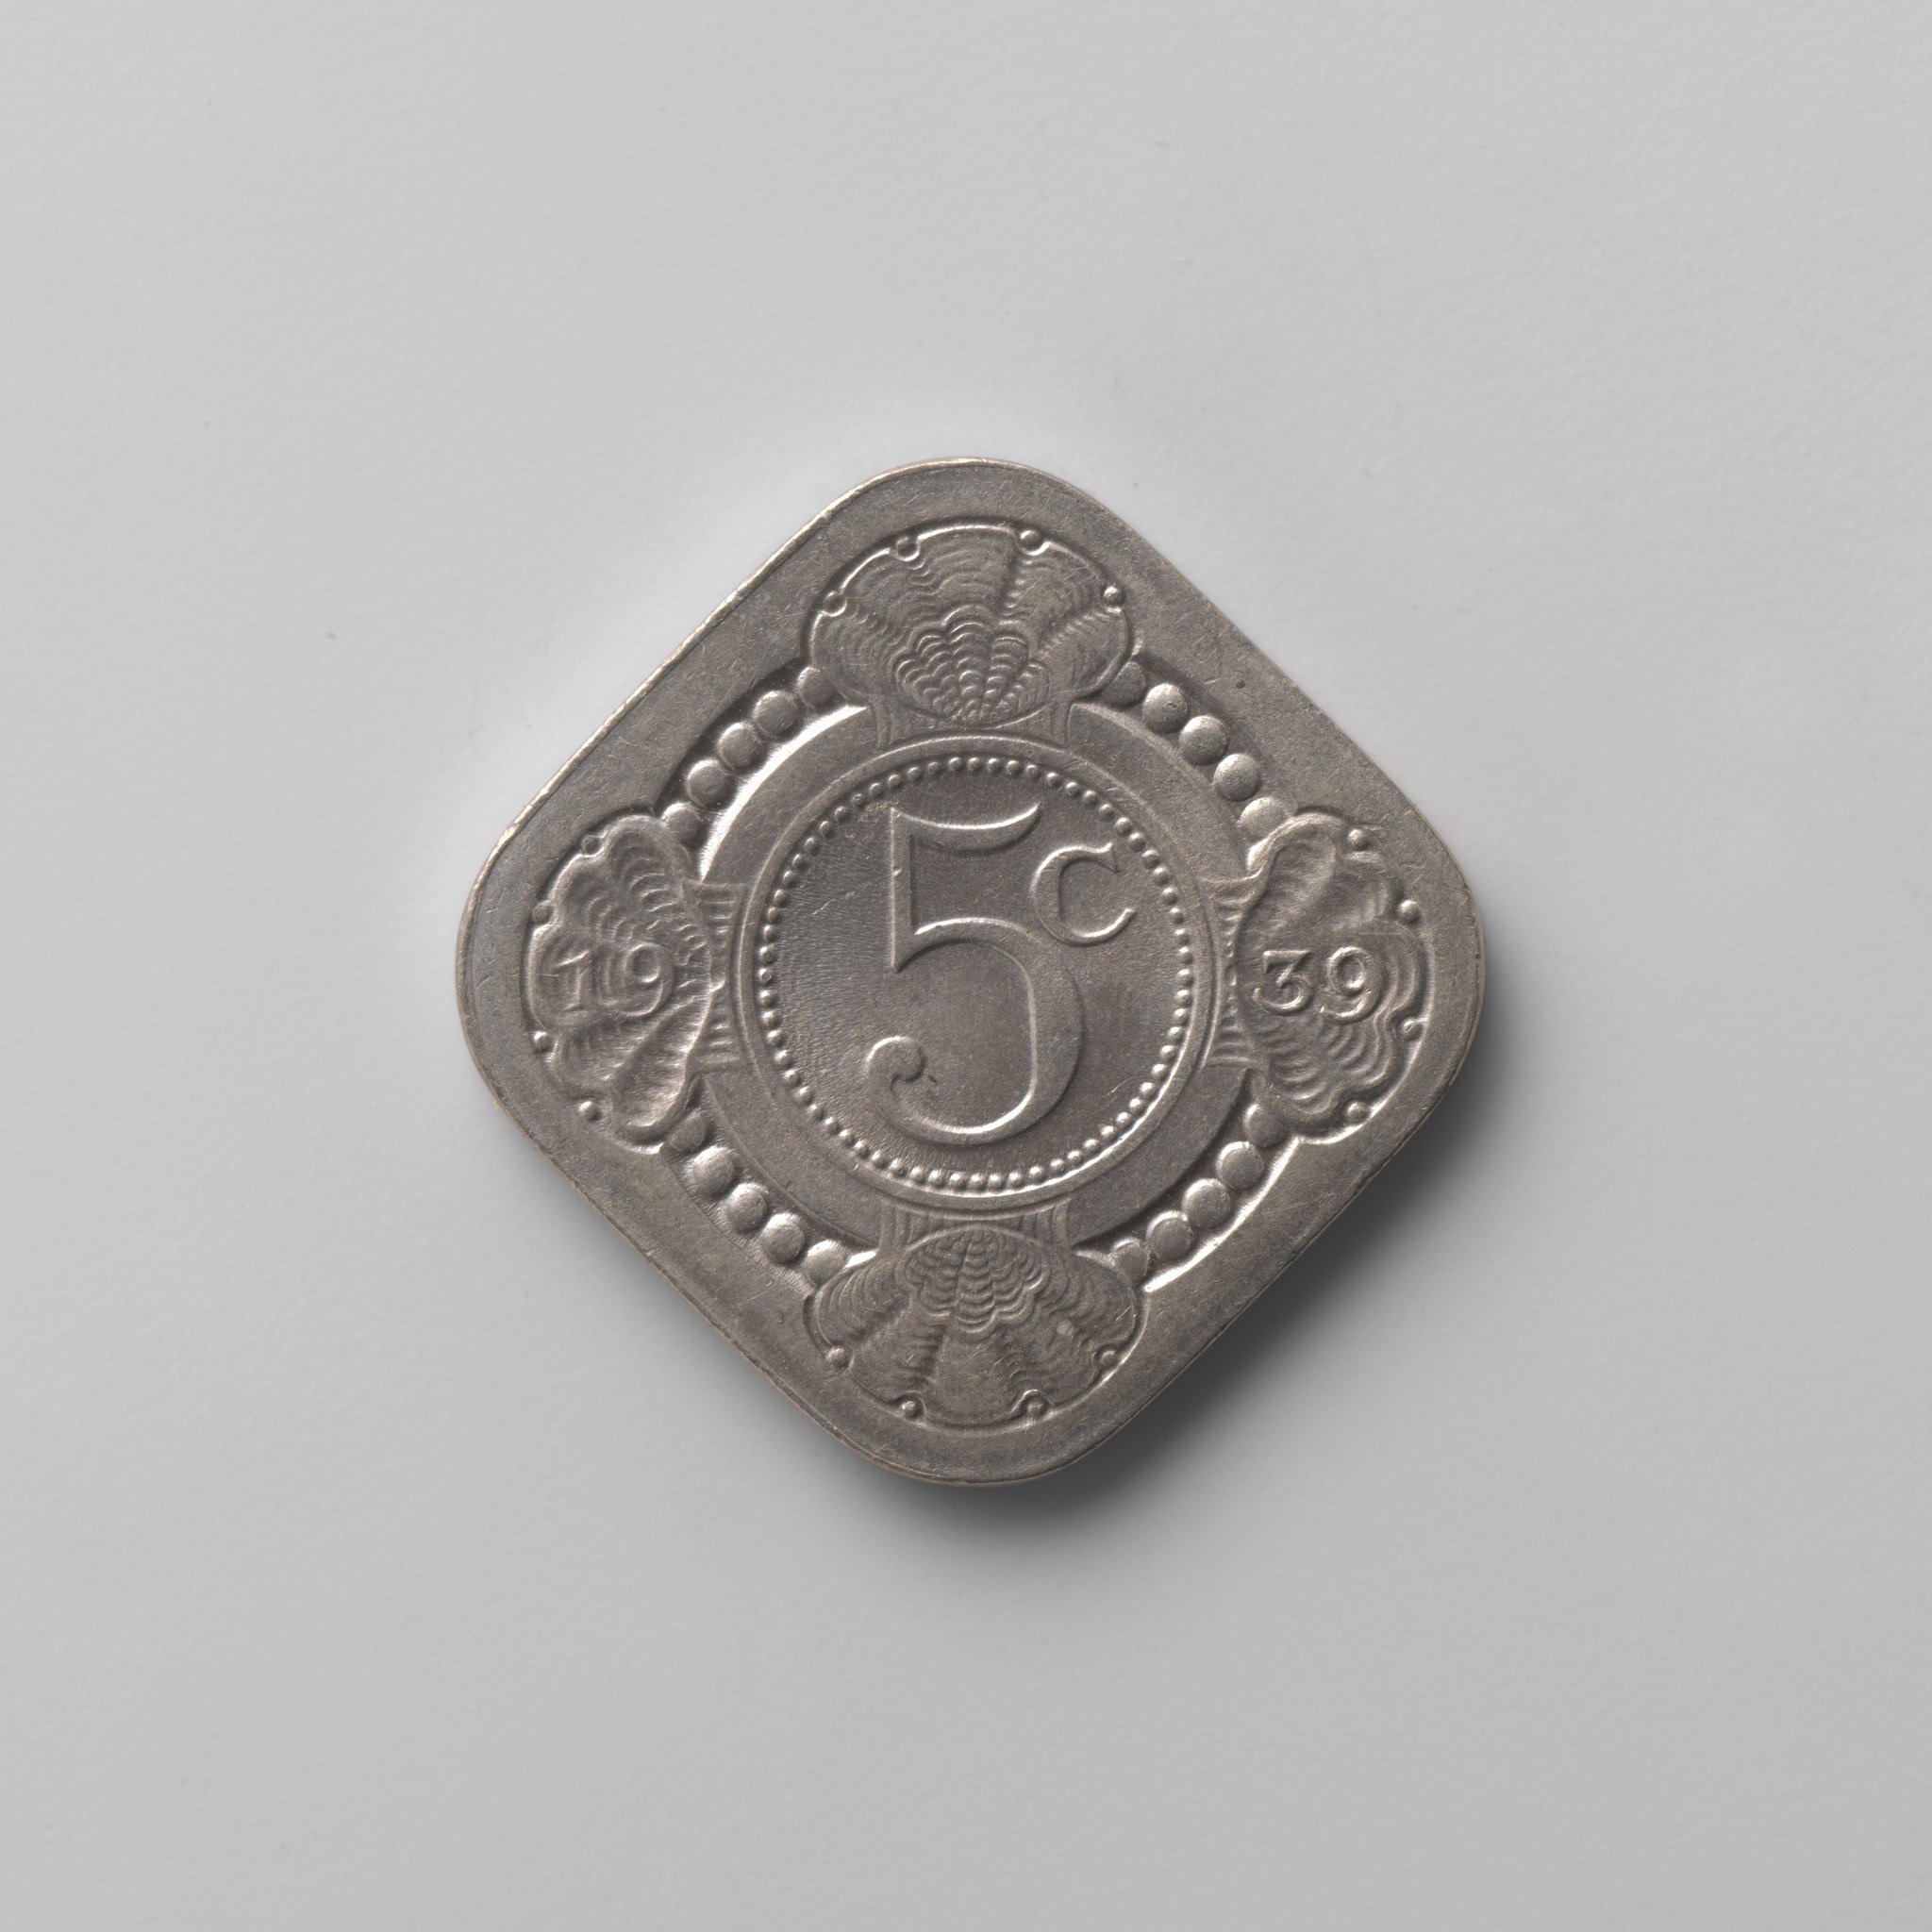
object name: coin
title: Nederlandse 5 cent,1939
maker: wilhelmina of the netherlands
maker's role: print maker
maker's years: 1880-1962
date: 1939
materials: nickel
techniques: striking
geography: utrecht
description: Vierkante nikkelen munt. Voorzijde: in hoeken versiering, daarbinnen twee cirkels, waarin landsaanduiding. Daarbinnen vruchtdragende tak van een oranje-appel. Keerzijde: in de vier hoeken schelpen-versiering, verbonden door parels. Daarbinnen waarde-aanduiding 5 C in parelrand. Jaartal in de twee schelpen links en rechts. Gladde rand.